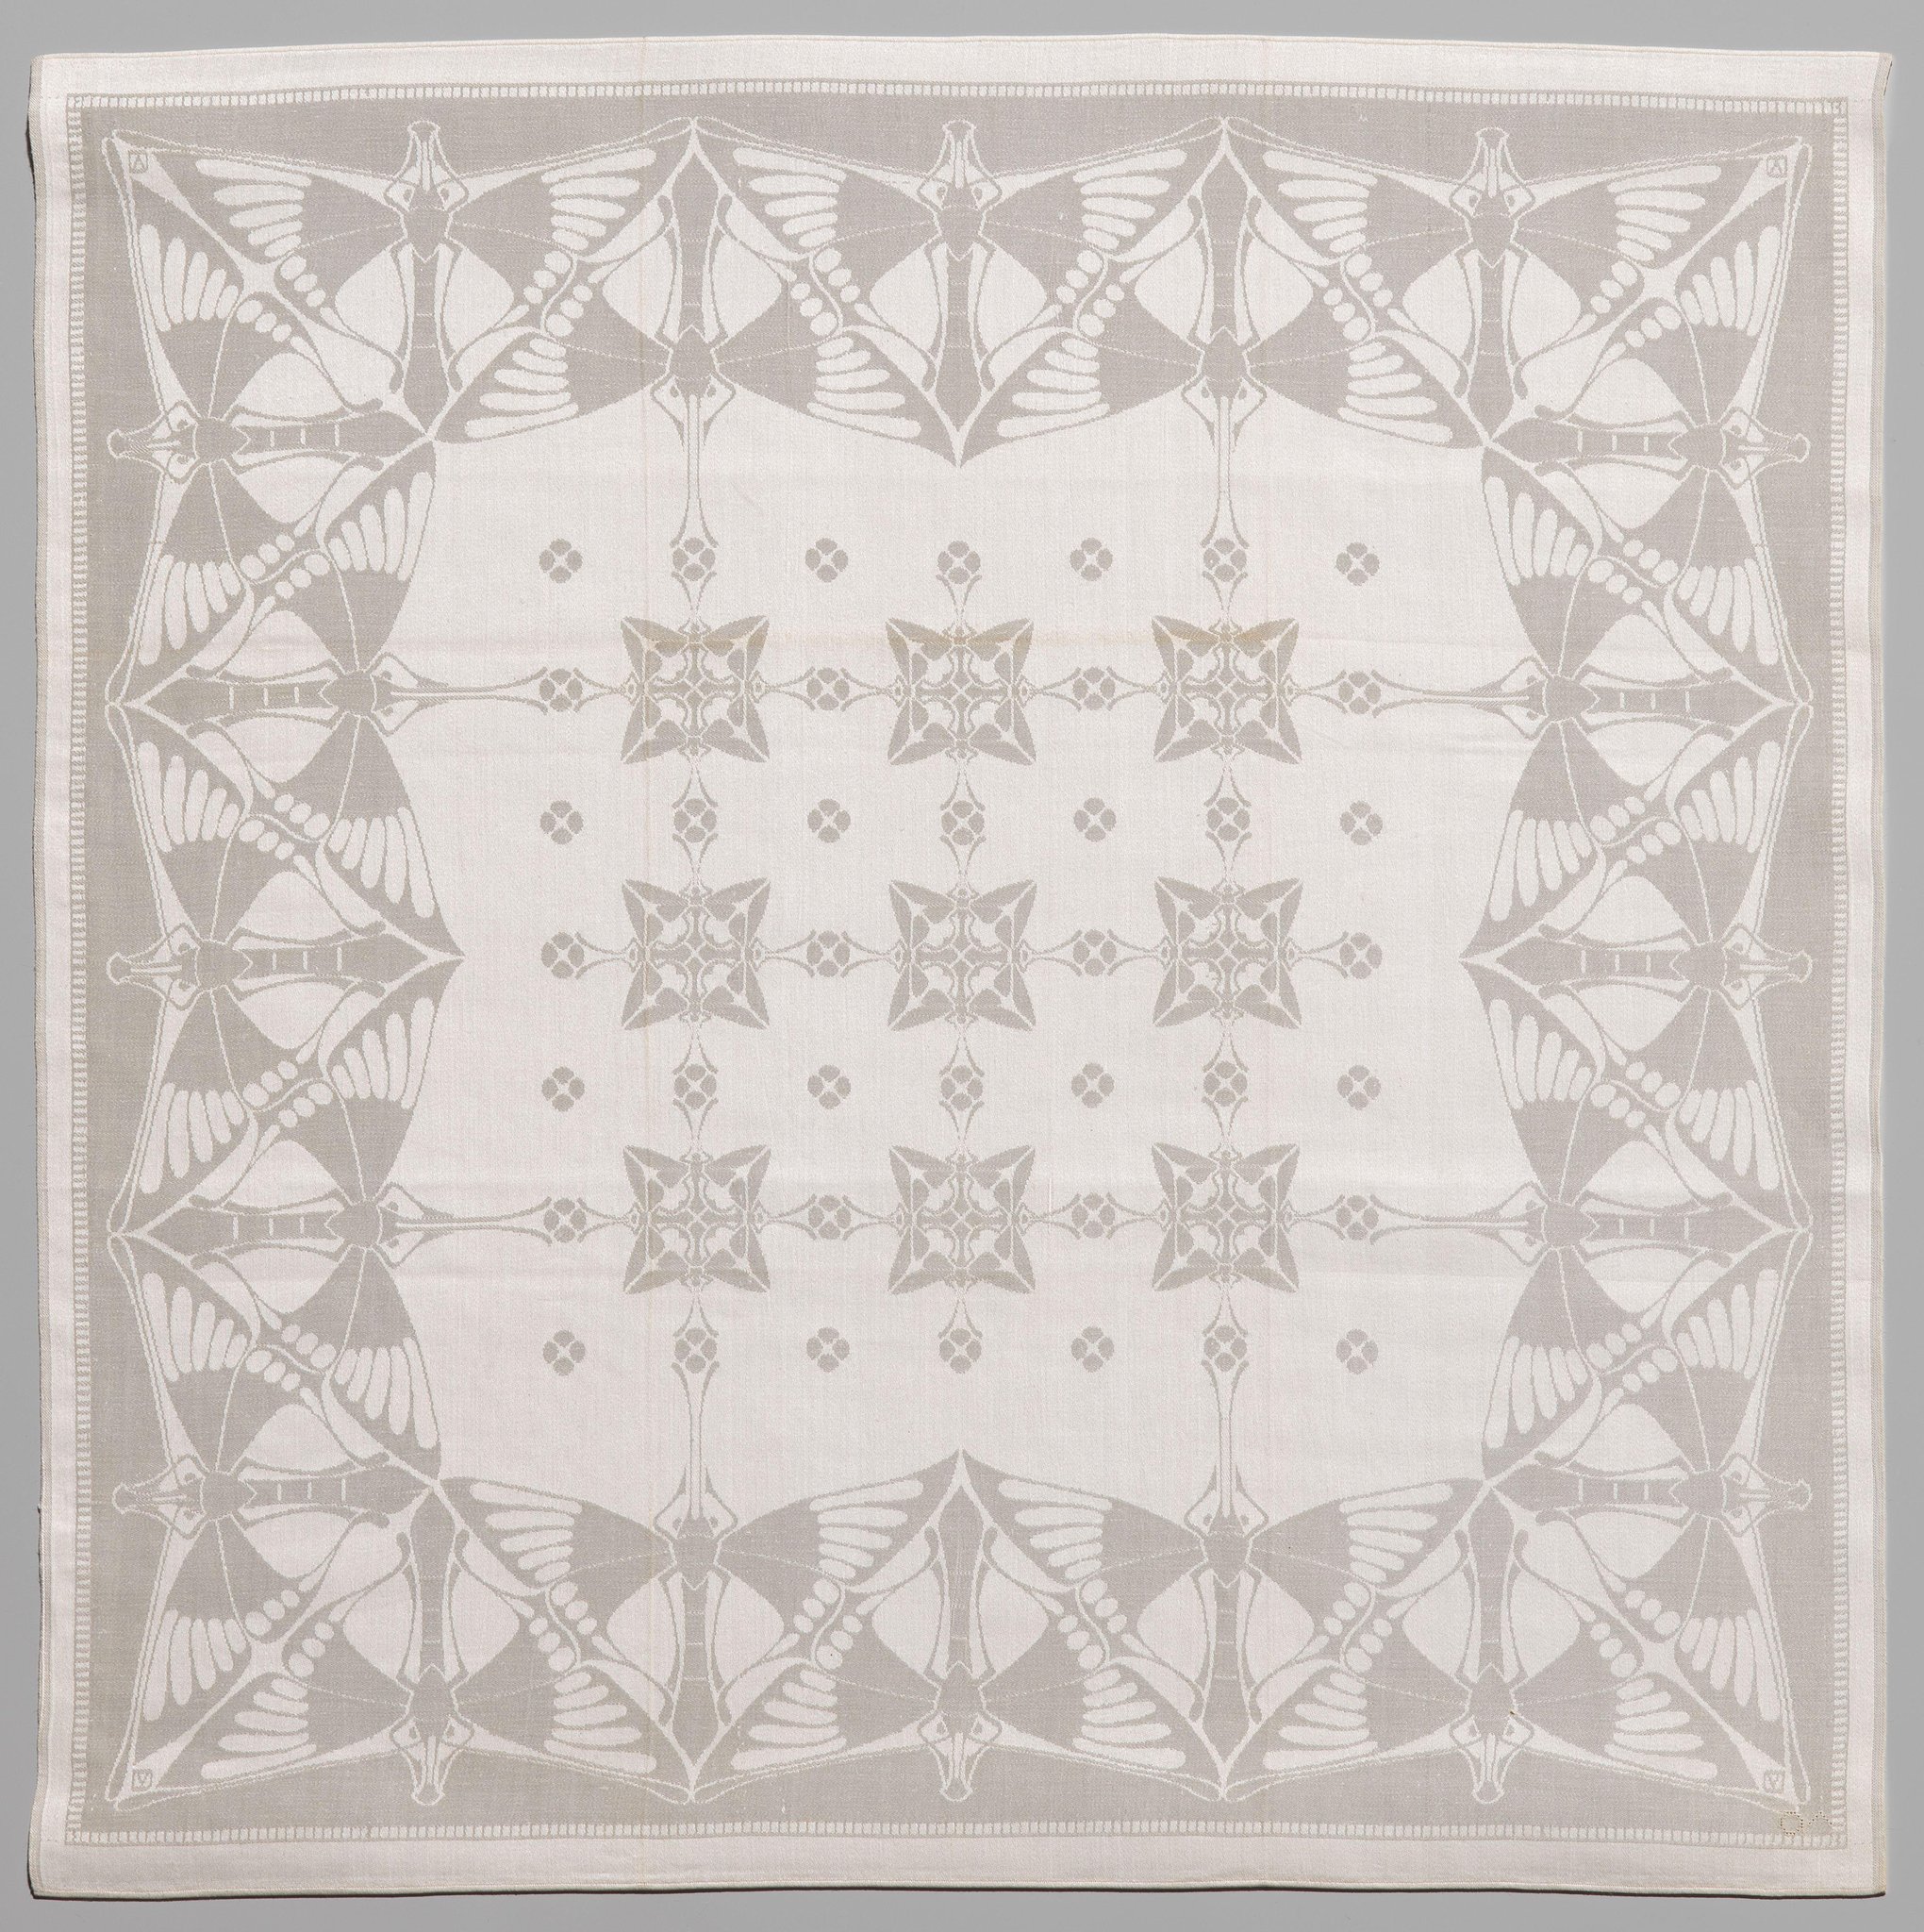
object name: napkin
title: Servet 'Vlinder' van linnendamast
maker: chris lebeau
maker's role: draughtsman, print maker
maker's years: 1878-1945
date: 1905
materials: linen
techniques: damask, weave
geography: eindhoven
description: Servet van linnendamast in vlindermotief. Het servet hoort bij vijf servetten (BK-1970-81-A t/m BK-1970-81-F) en een tafellaken (BK-1970-80).